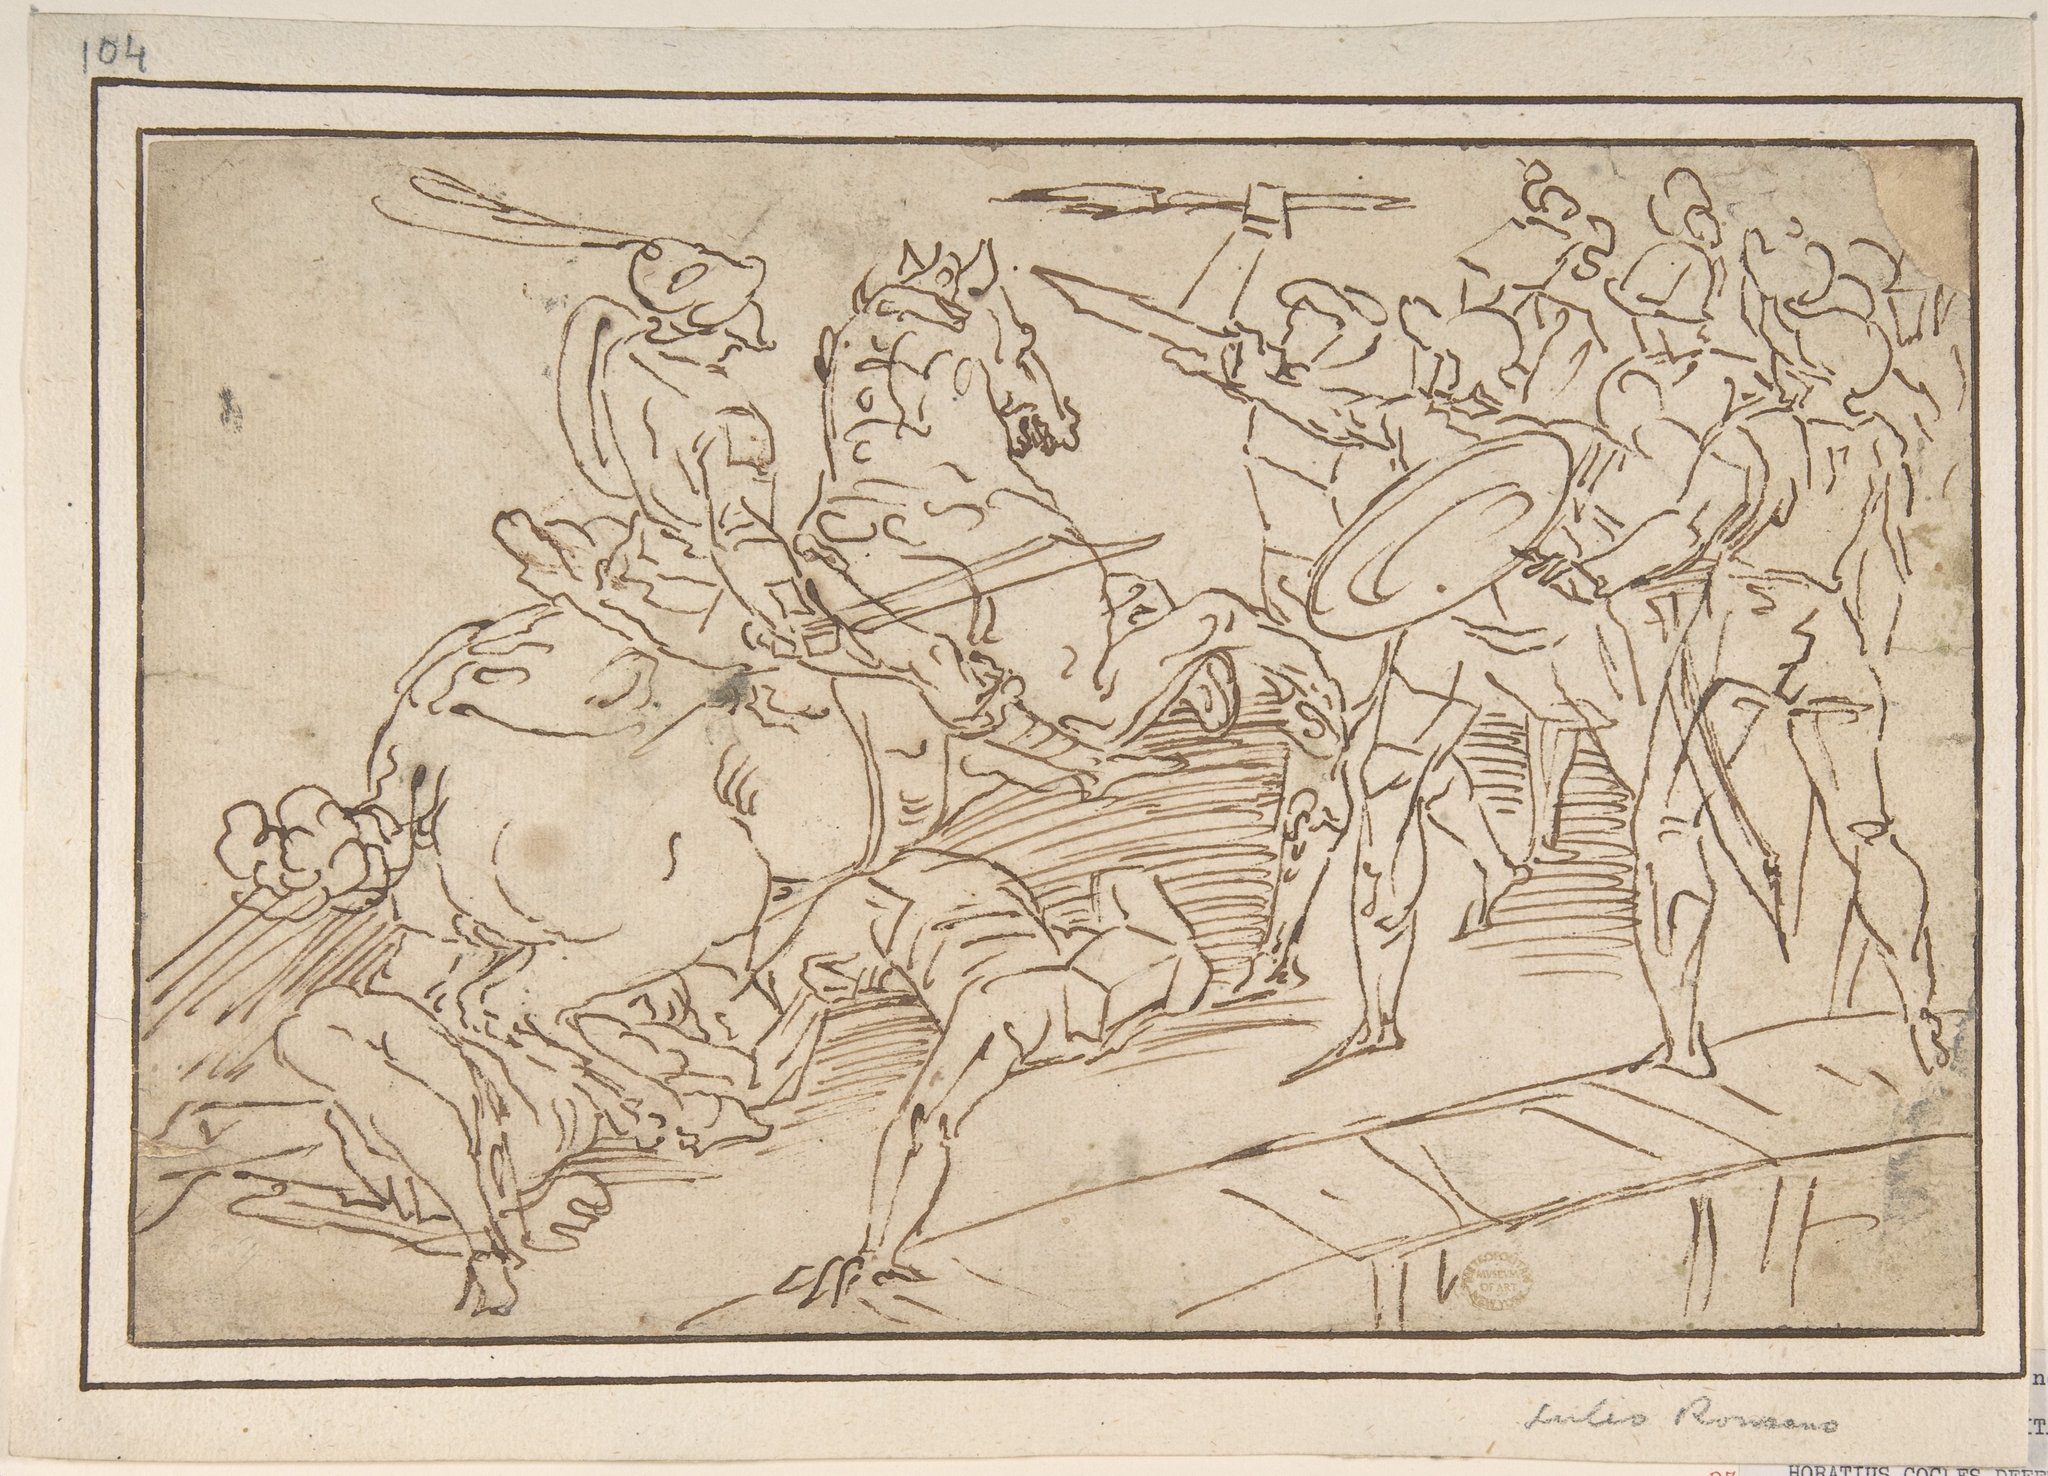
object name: drawing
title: Horatius Cocles Defending the Bridge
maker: luca cambiaso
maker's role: artist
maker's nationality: italian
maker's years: 1527-1585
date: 1527-1585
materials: ink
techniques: pen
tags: soldiers,shields,weapons,men,horses